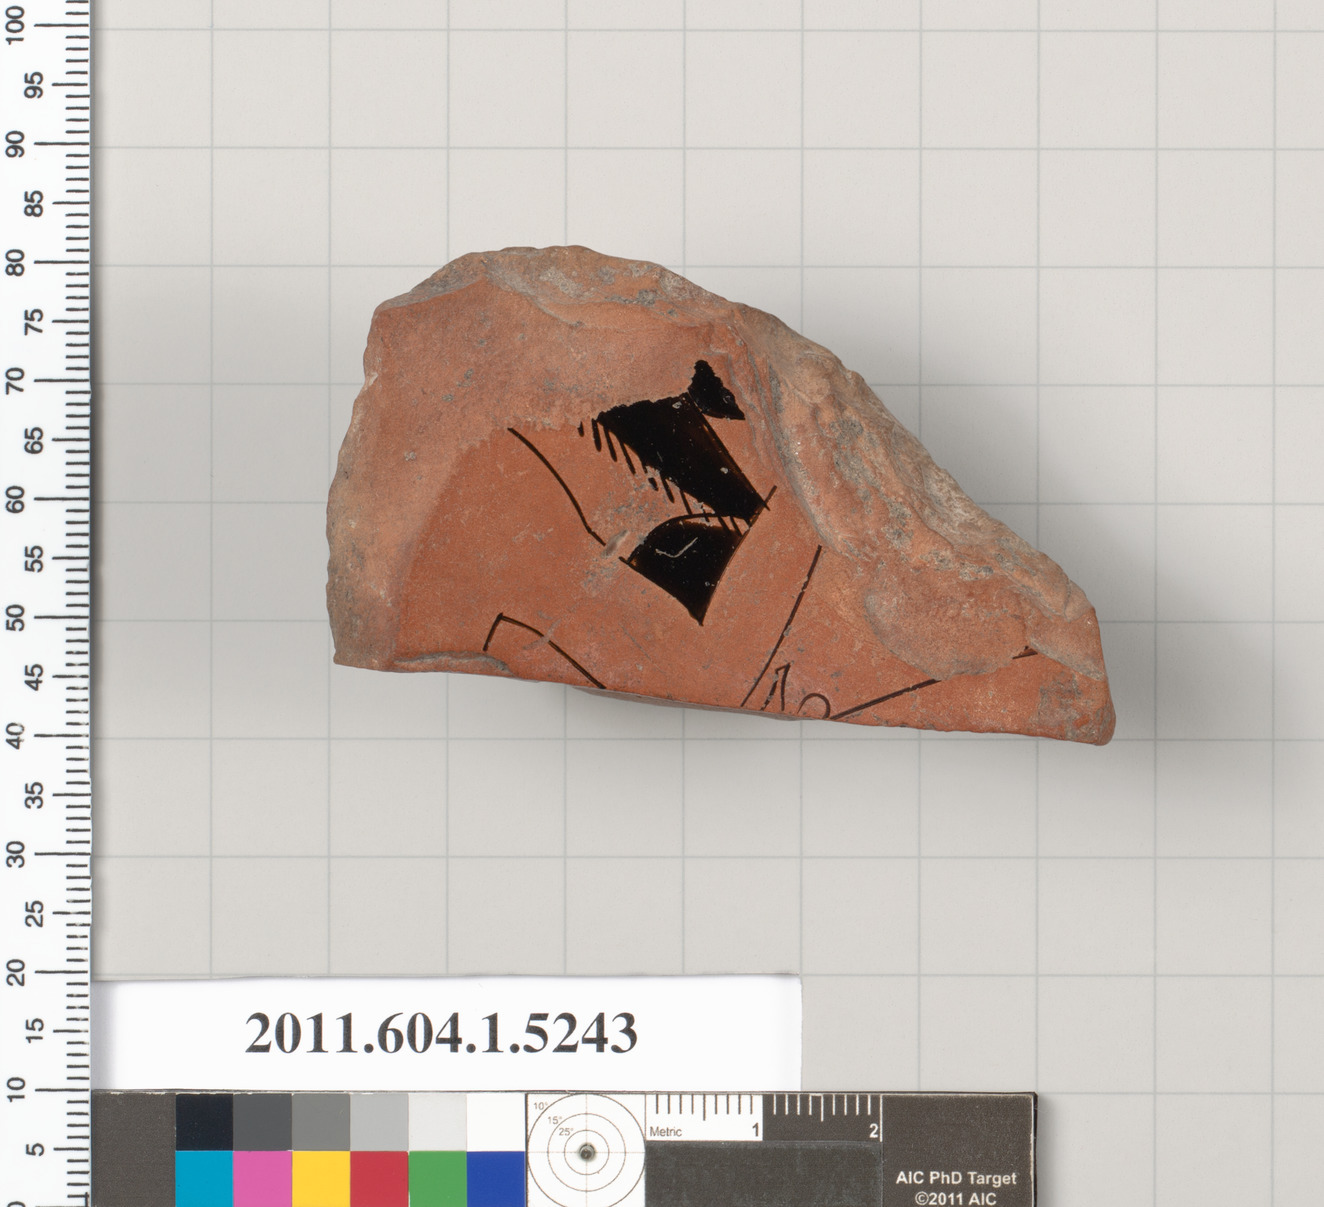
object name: kylix fragment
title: Terracotta fragment of a kylix (drinking cup)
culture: greek, attic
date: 520-500 BCE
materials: terracotta